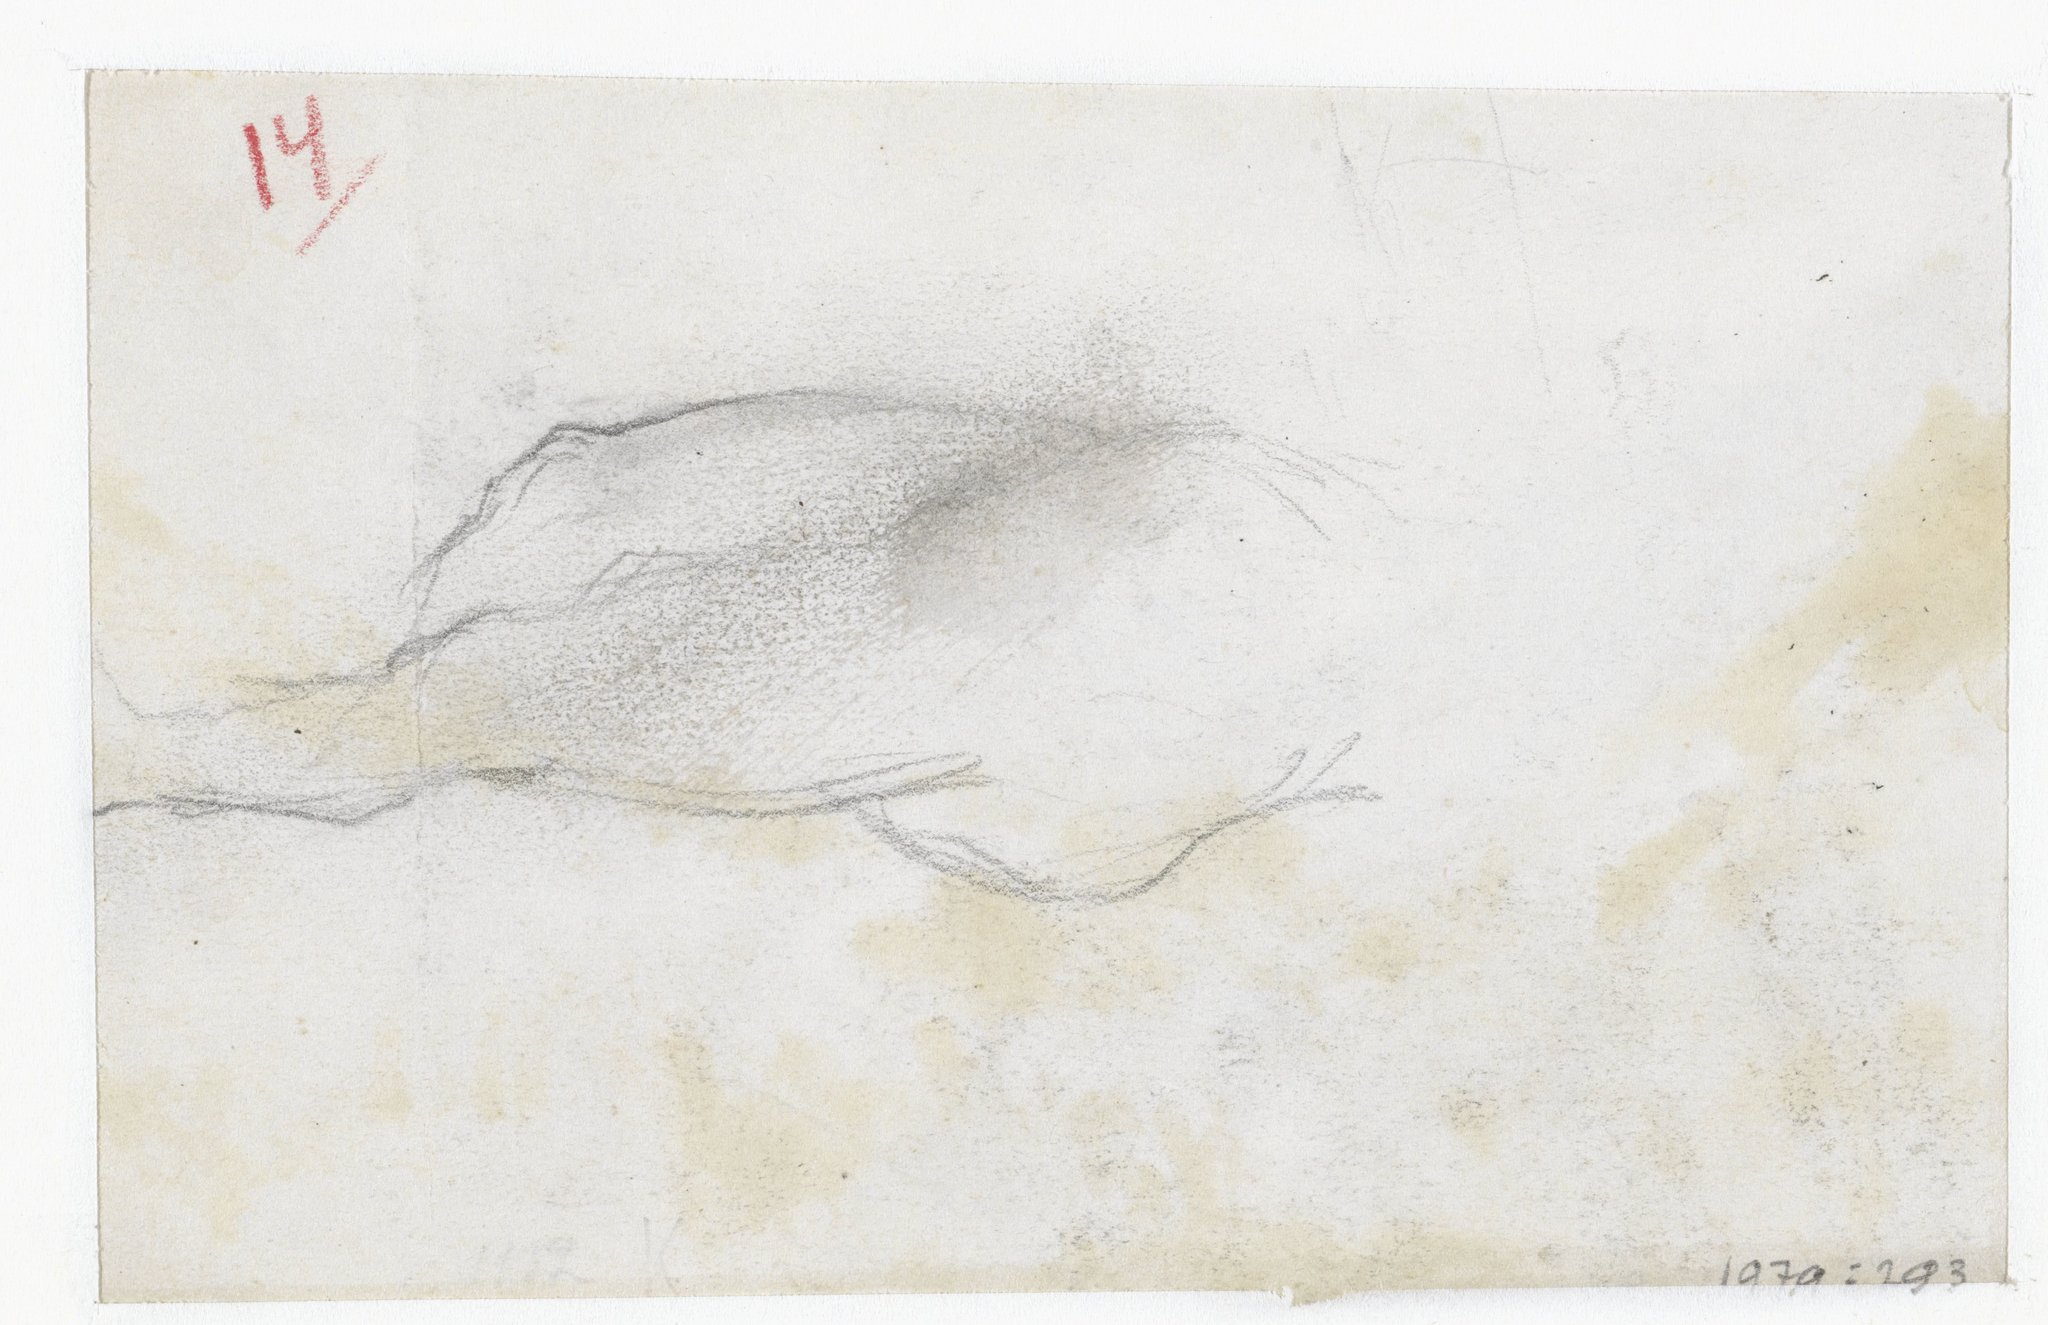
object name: drawing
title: Schets van een landschap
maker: jozef israëls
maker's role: draughtsman, painter, print maker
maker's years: 1824-1911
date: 1834-1911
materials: paper, pencil